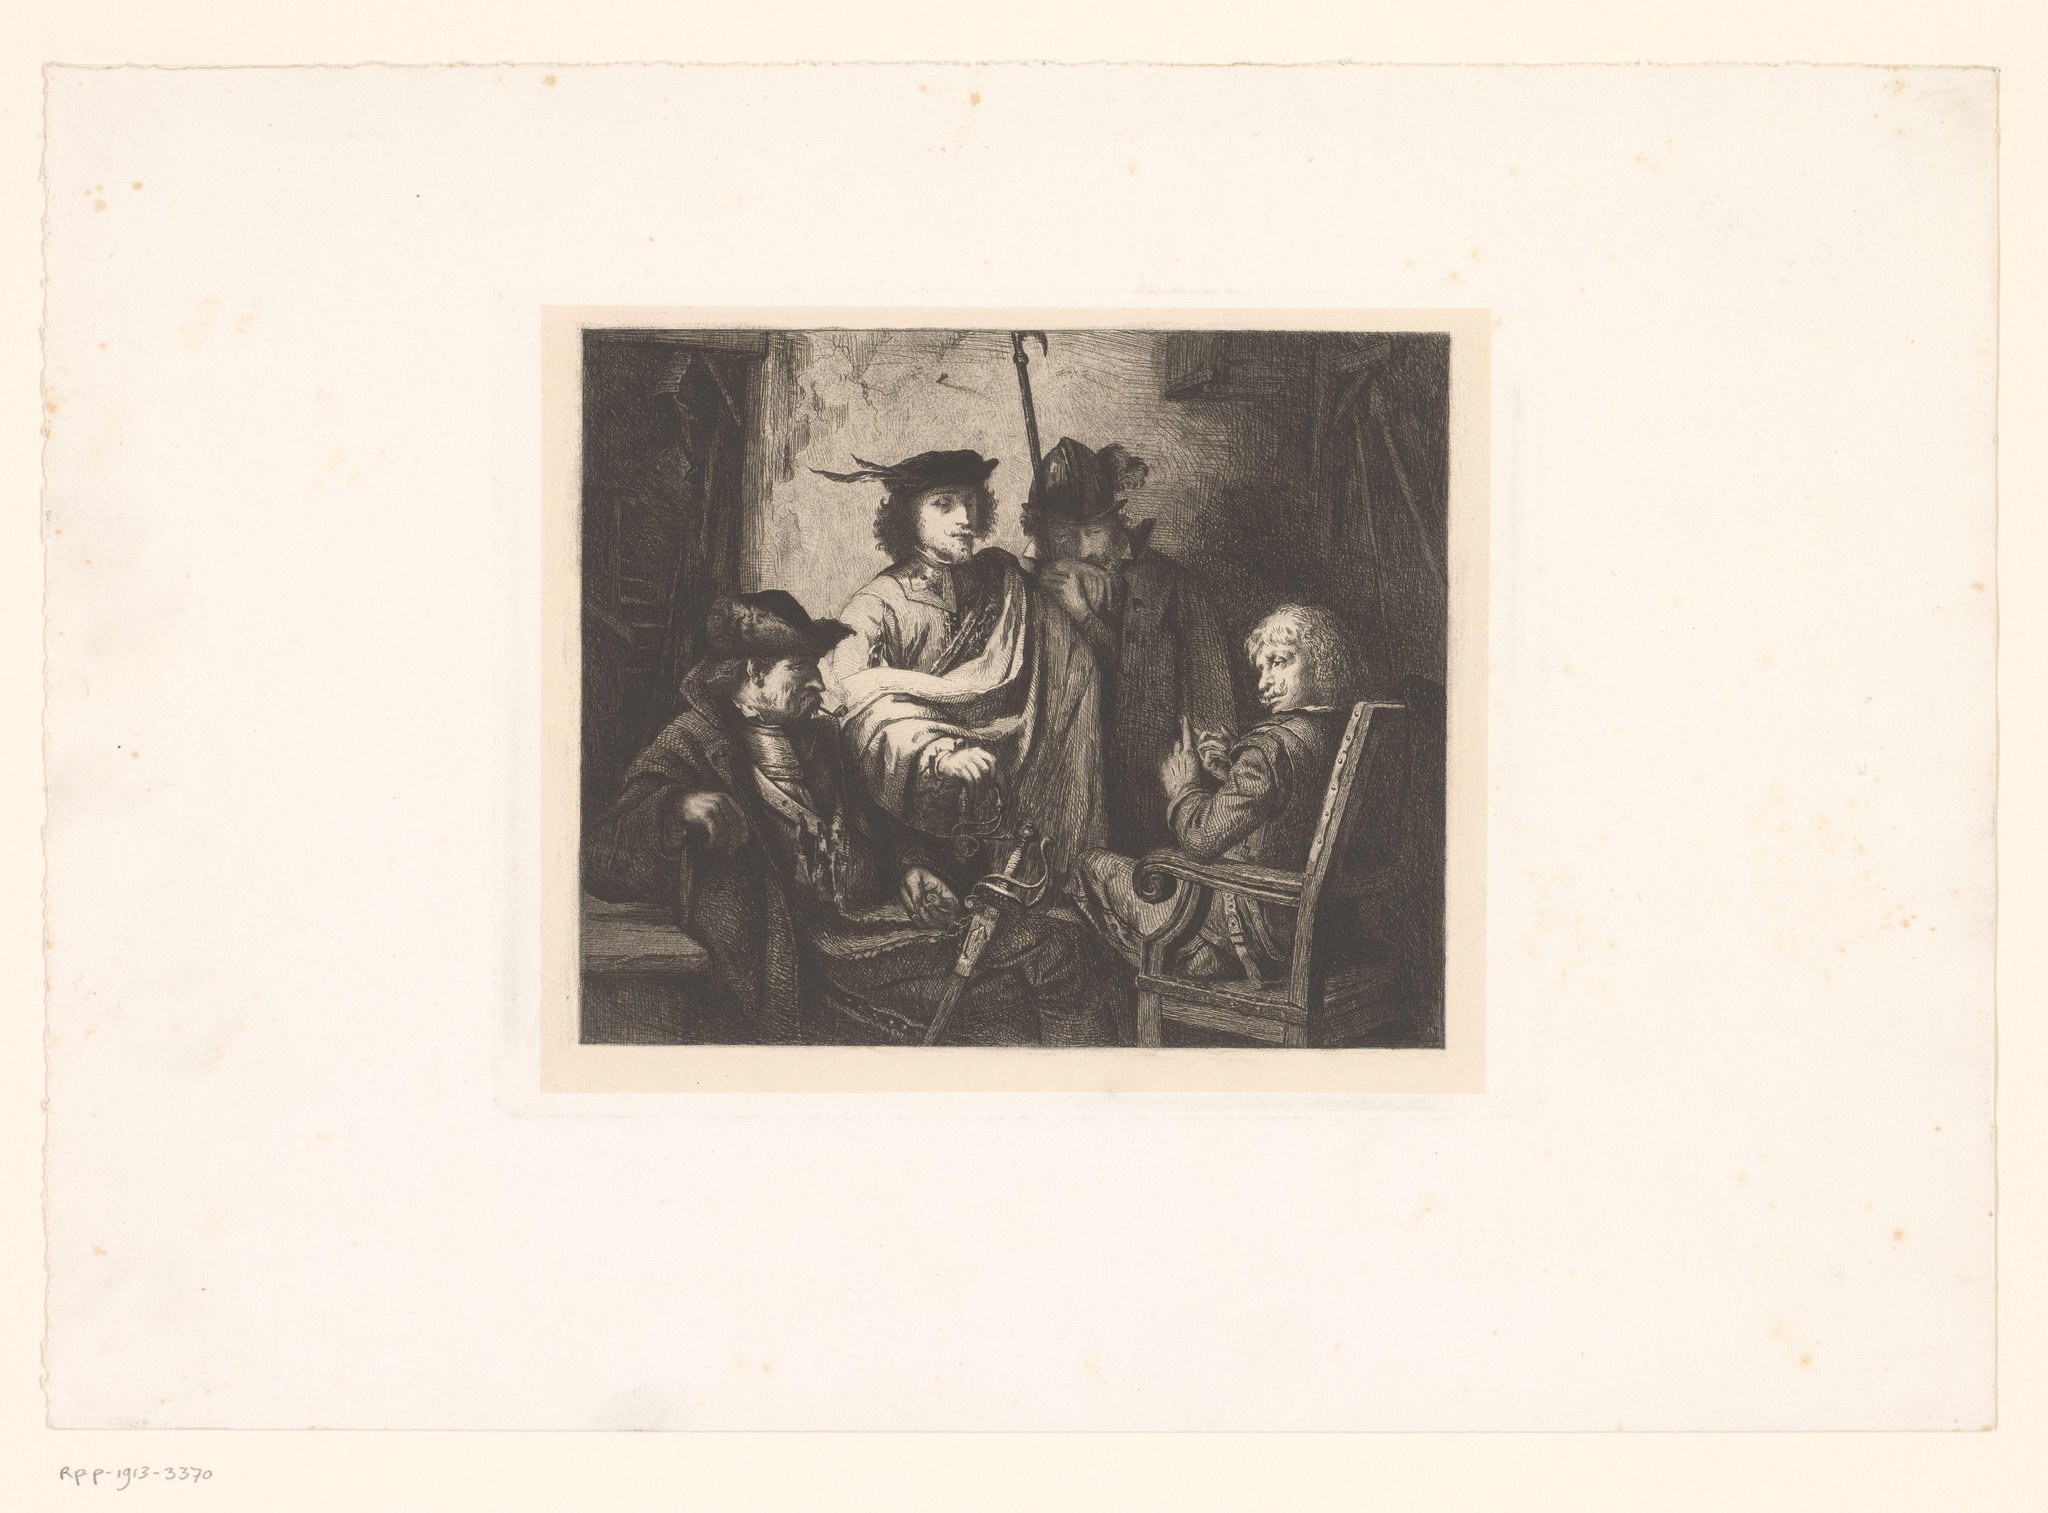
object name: print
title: Vier krijgslieden in gesprek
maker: piet verhaert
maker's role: print maker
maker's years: 1852-1908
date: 1862-1908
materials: paper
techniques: etching, retroussage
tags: adult man (+ four persons), pipe ~ tobacco, hacking and thrusting weapons: sword, the soldier; the soldier's life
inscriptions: collector's mark: Lugt 2228